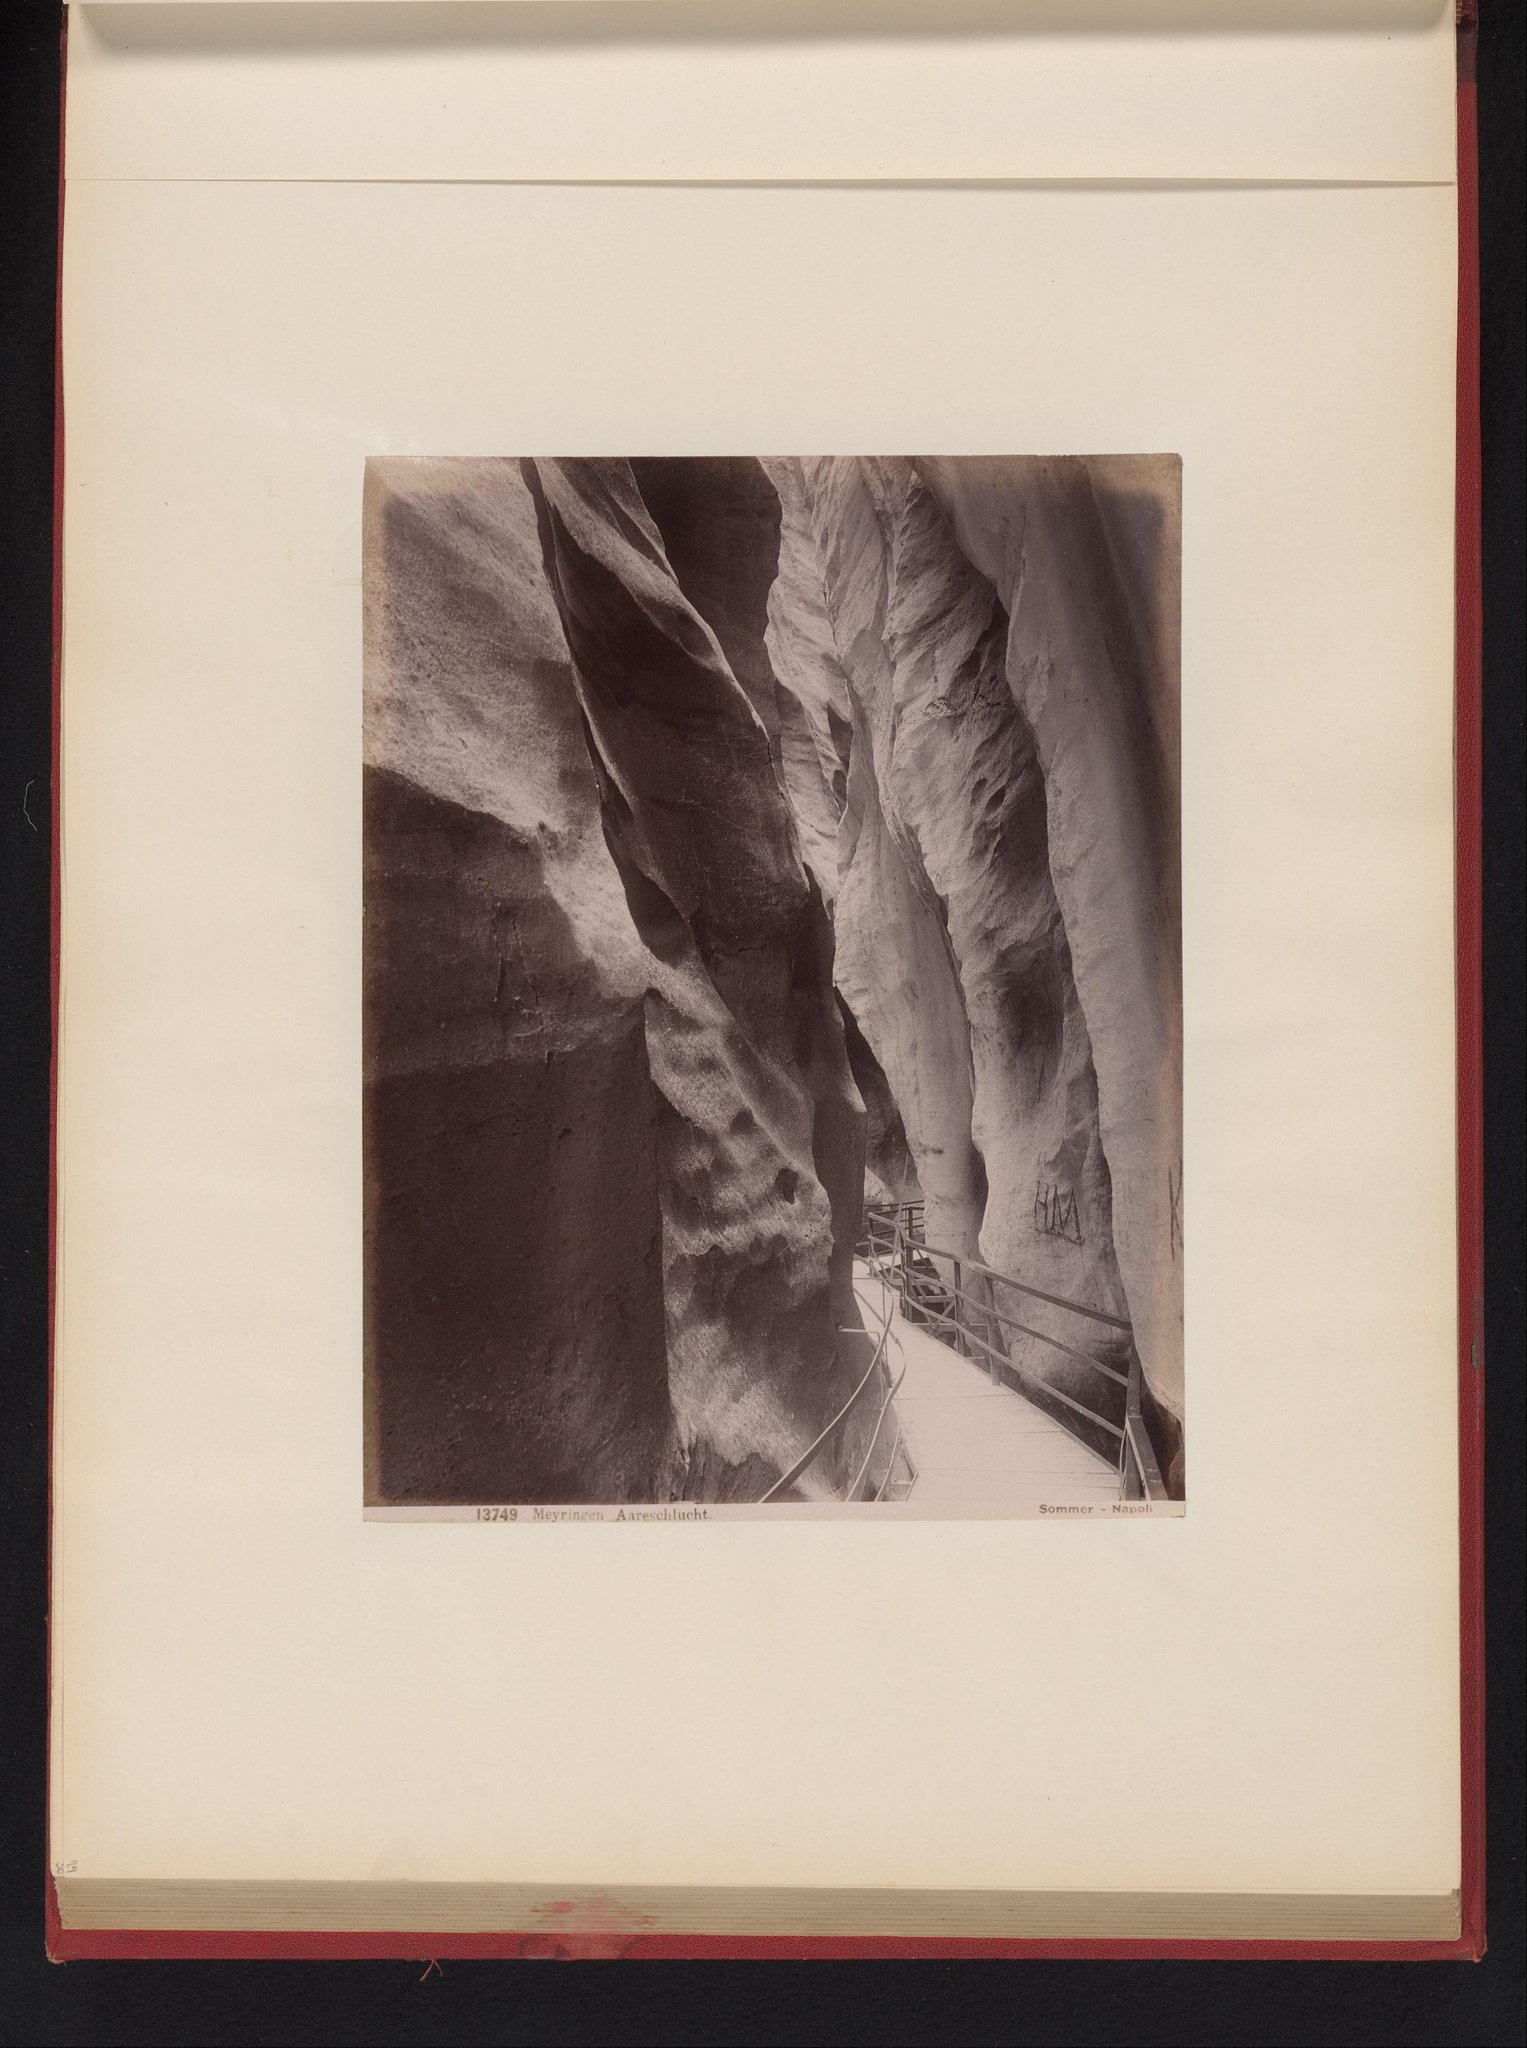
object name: photograph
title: Looppad door de Aareschlucht te Zwitserland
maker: giorgio sommer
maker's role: fotograaf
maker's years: 1834-1914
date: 1880-1900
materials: photographic support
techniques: albumen print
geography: meiringen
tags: ravine, chasm, abyss, canyon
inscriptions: inscription: ‘13749 Meyringen Aareschlucht. Sommer - Napoli’